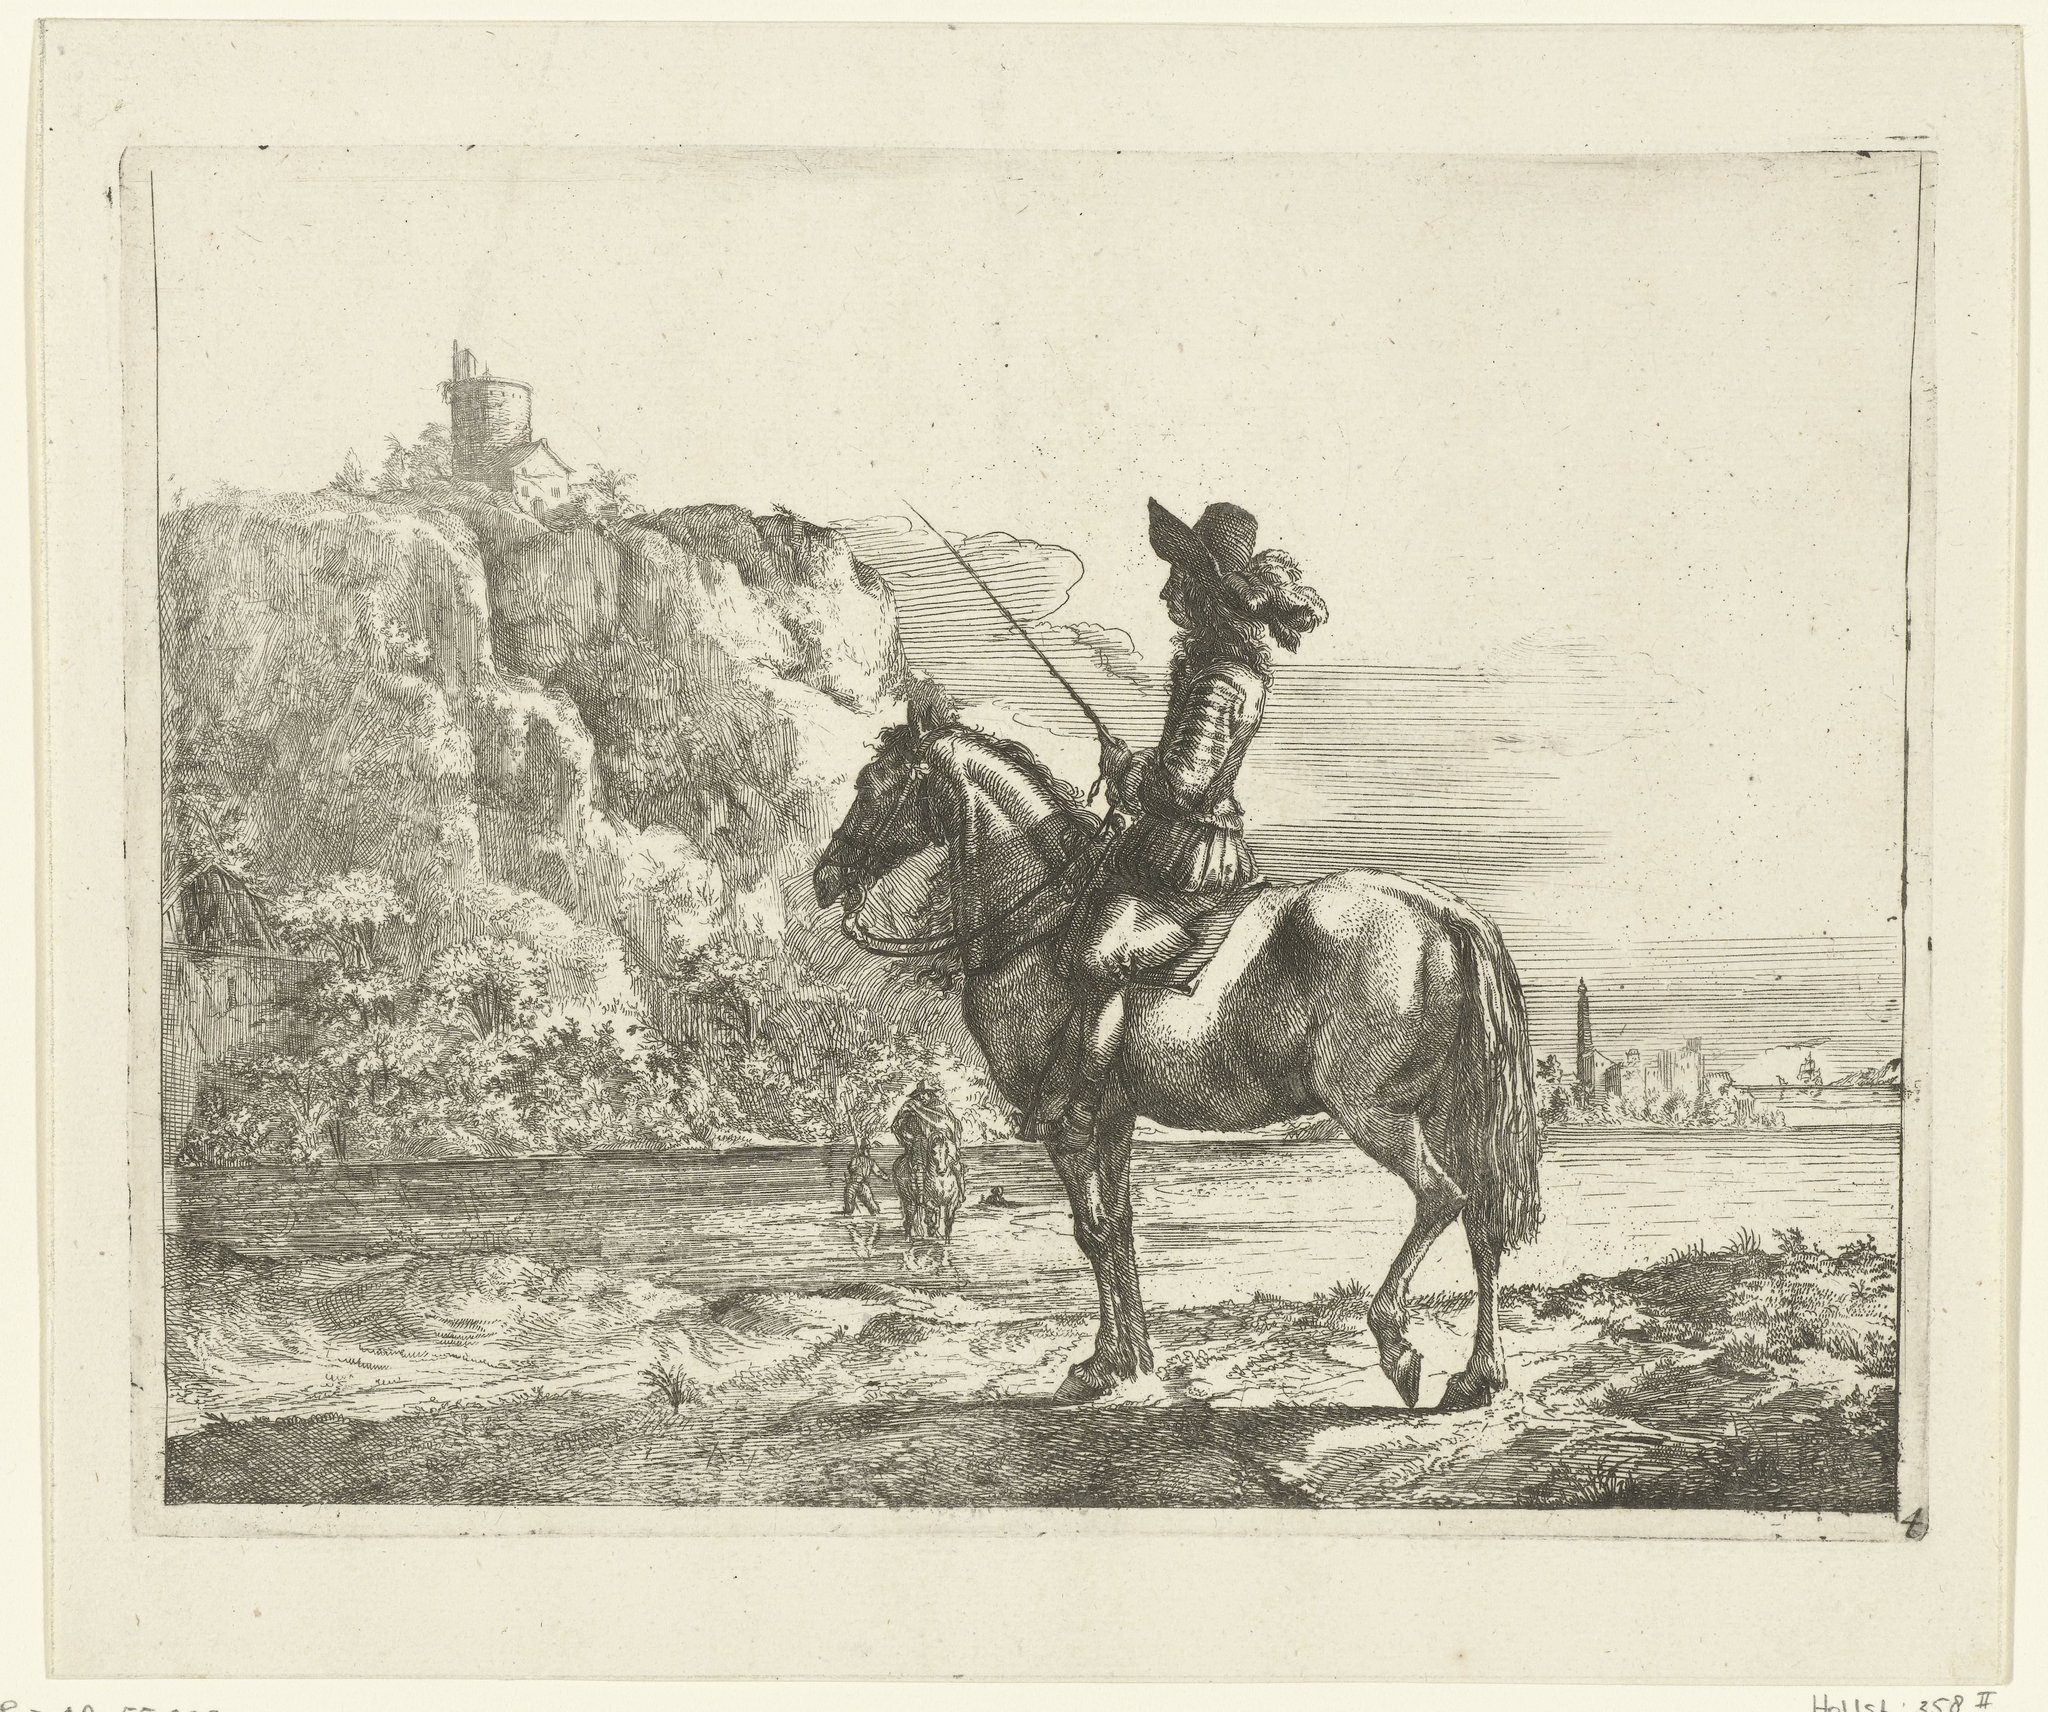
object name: print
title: Ruiter bij een rivier.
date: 1655-1667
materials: paper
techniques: etching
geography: netherlands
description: Ruiter bij een rivier. Aan de overkant van de rivier een grote rots met een gebouw.